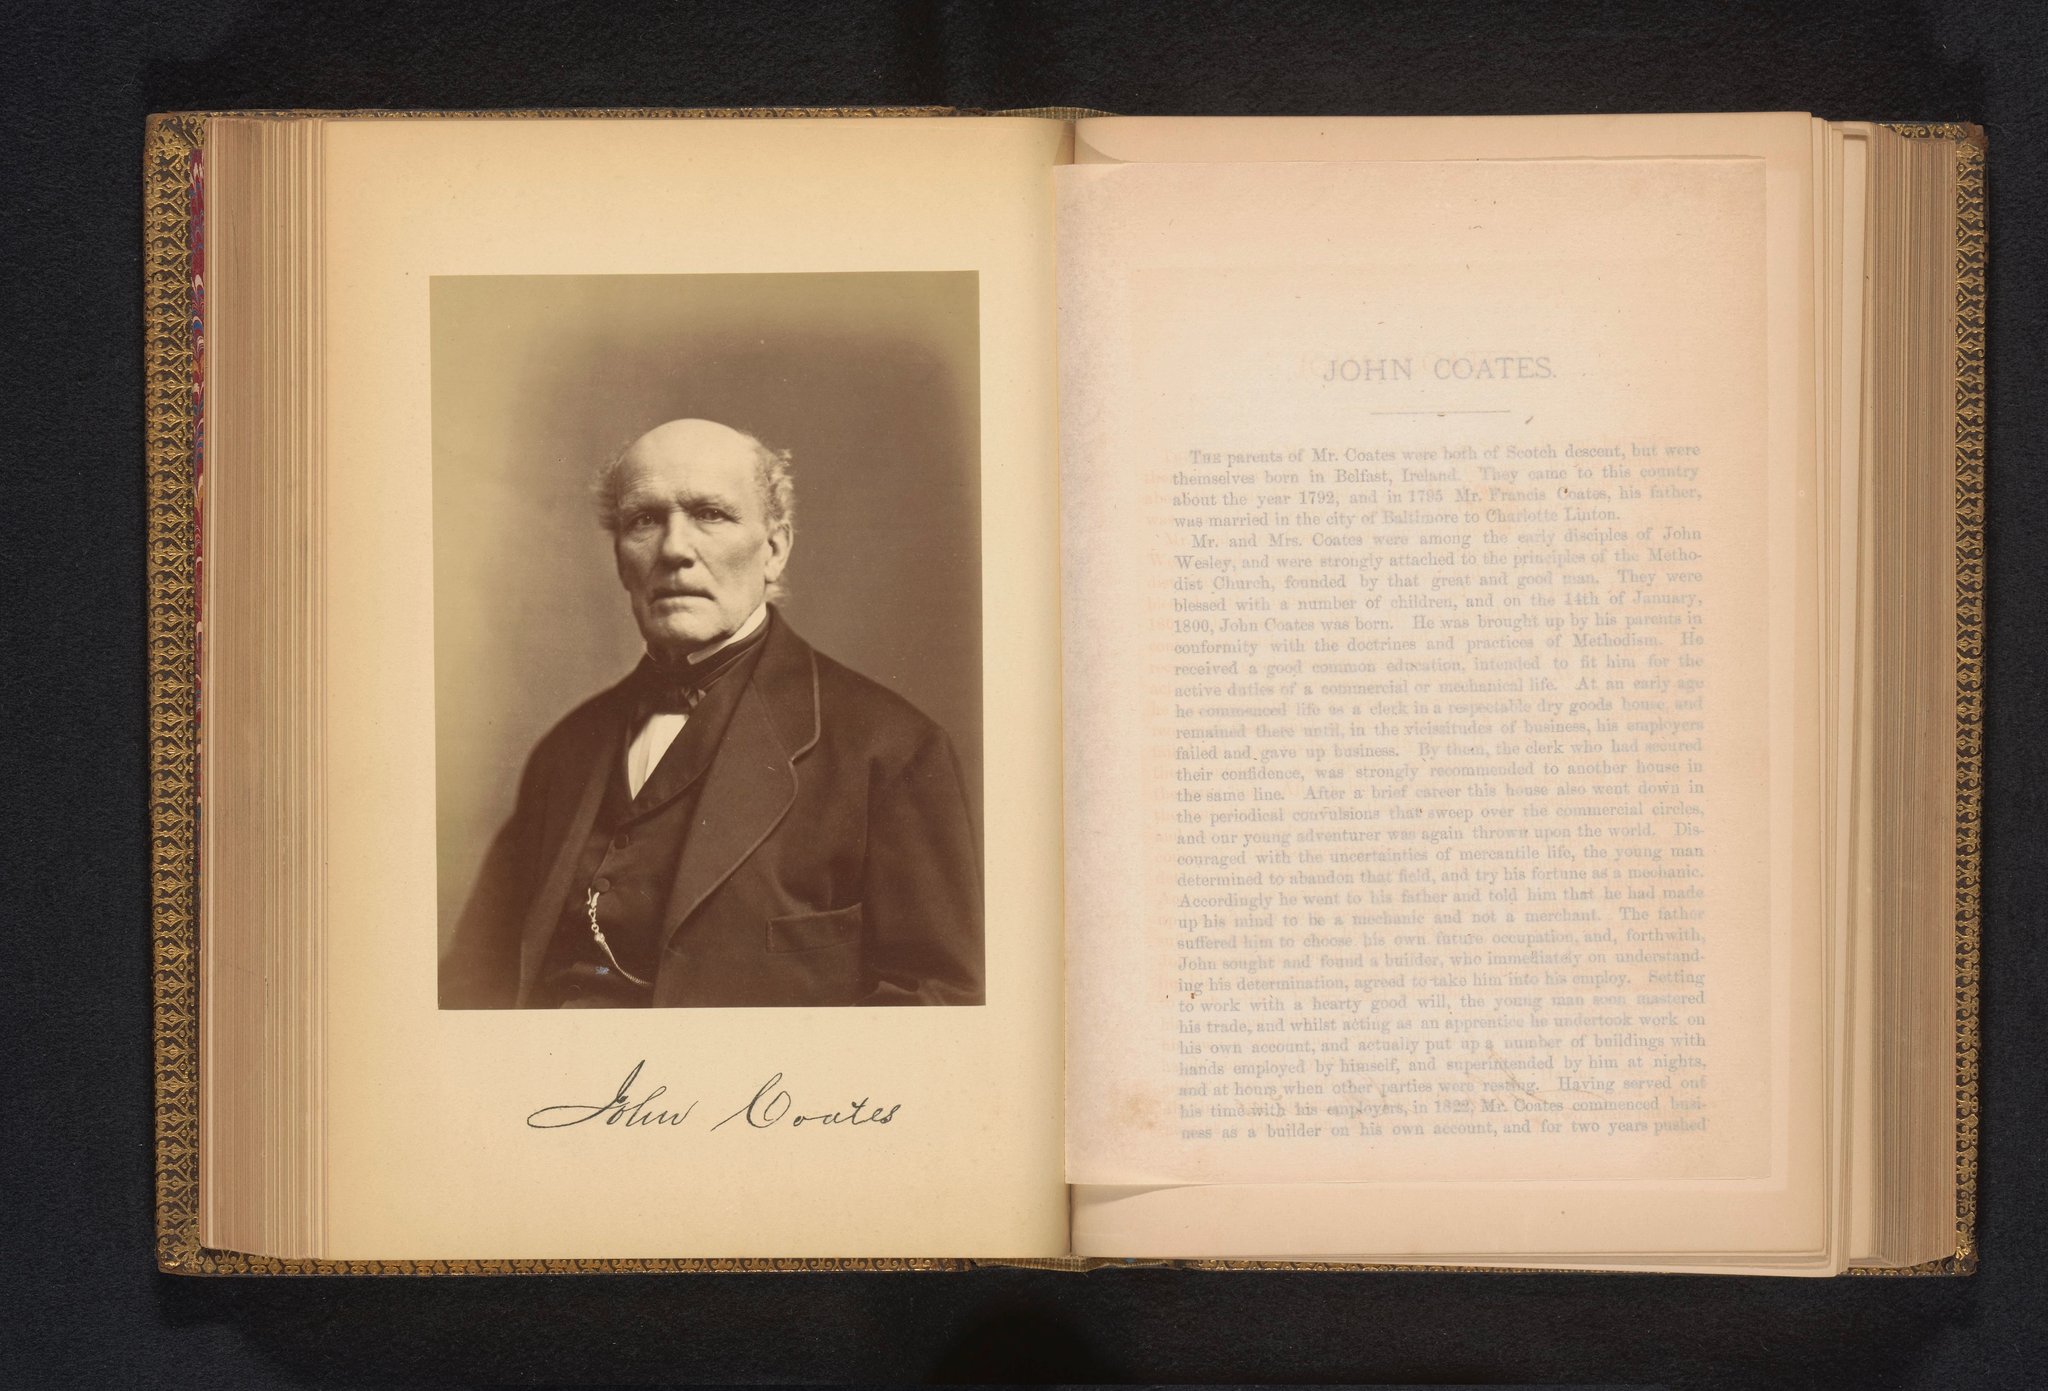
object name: photograph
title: Portret van John Coates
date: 1866-1871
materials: photographic support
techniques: albumen print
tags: historical persons